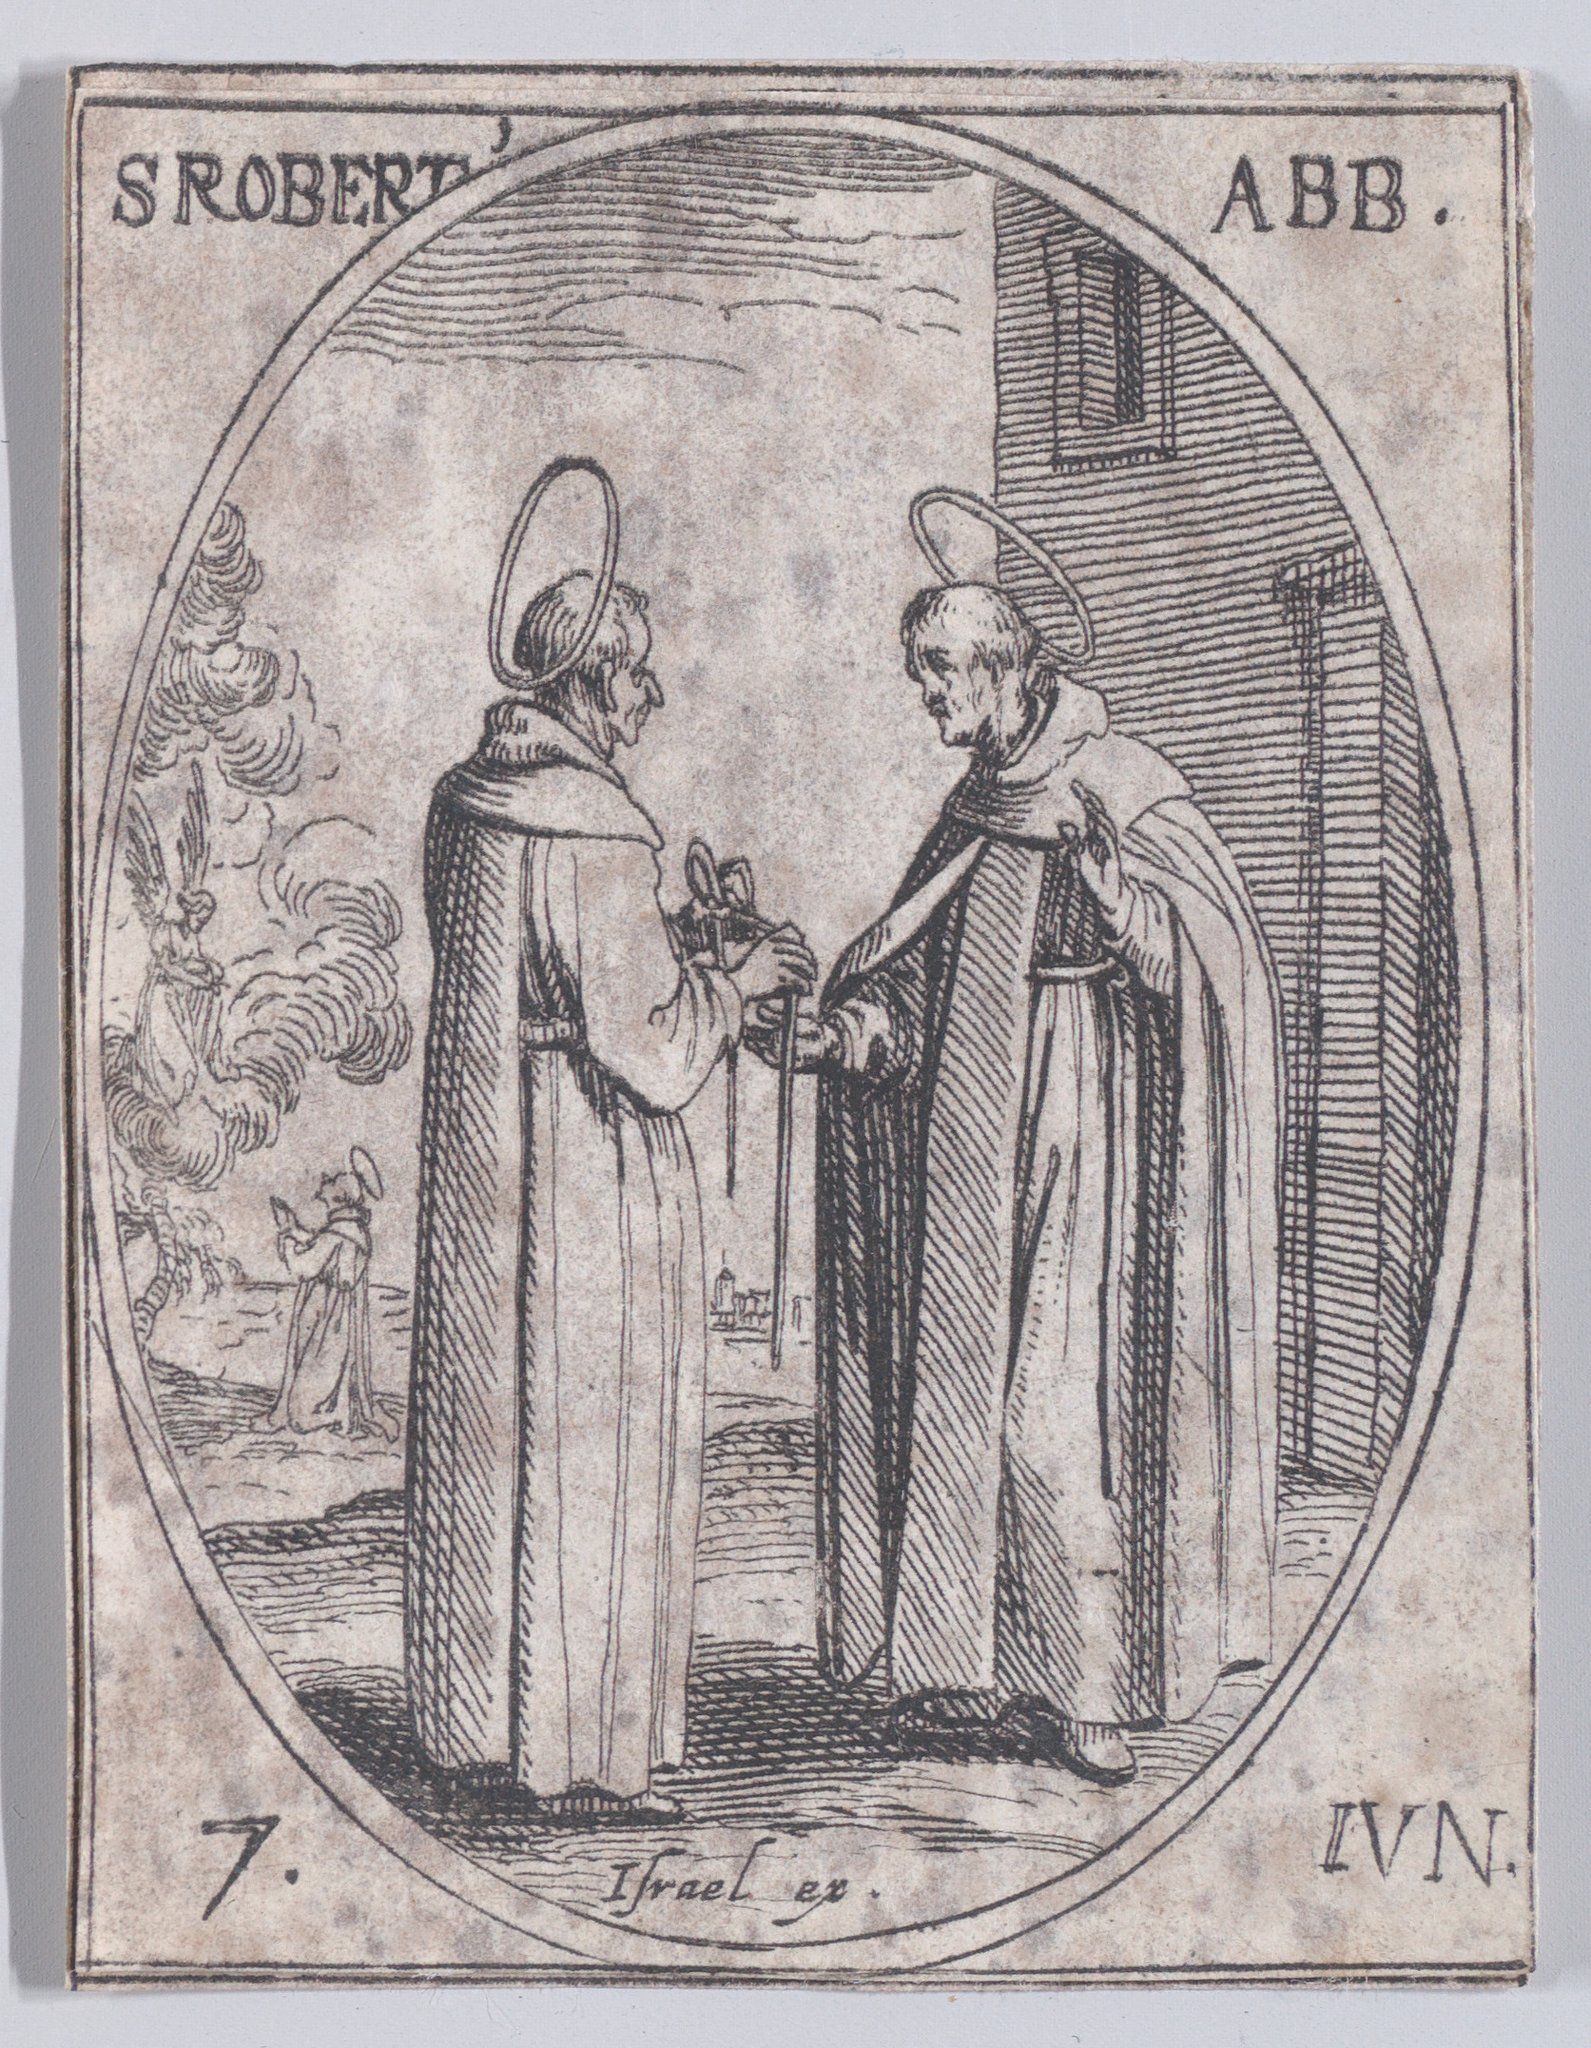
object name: print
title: St. Robert, abbé (St. Robert, Abbot), June 7th, from "Les Images De Tous Les Saincts et Saintes de L'Année" (Images of All of the Saints and Religious Events of the Year)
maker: jacques callot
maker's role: artist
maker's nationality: french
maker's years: 1592-1635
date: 1636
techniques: etching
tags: men,saints